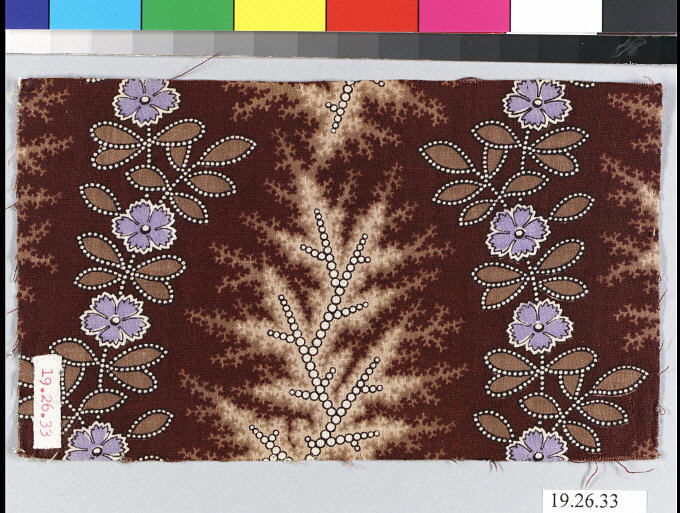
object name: sample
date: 1840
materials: cotton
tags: flowers,leaves